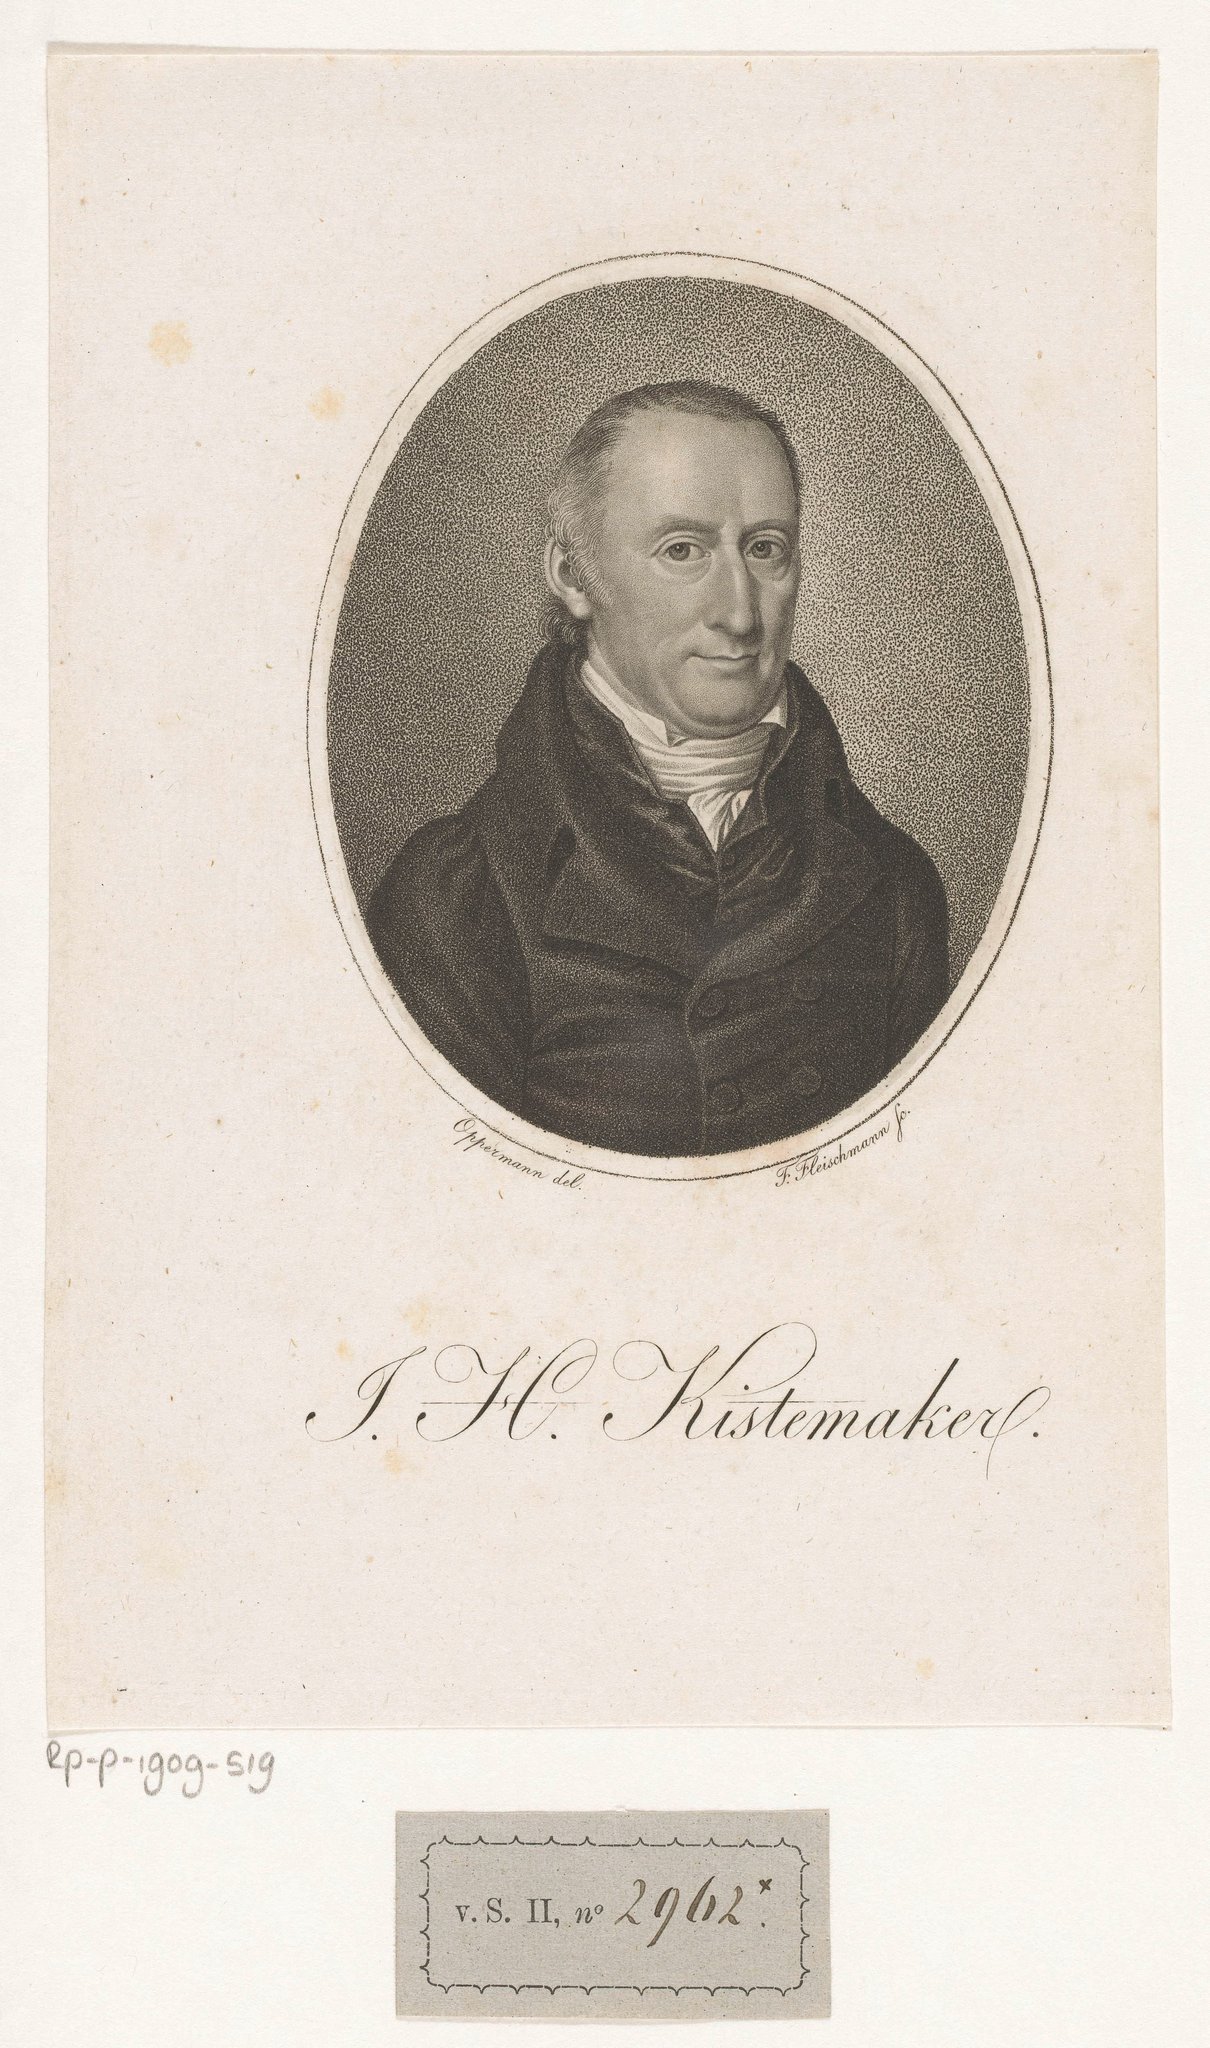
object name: print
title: Portret van Johann Hyacinth Kistemaker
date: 1801-1834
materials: paper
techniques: stippling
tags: historical persons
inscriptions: collector's mark: Lugt 2228